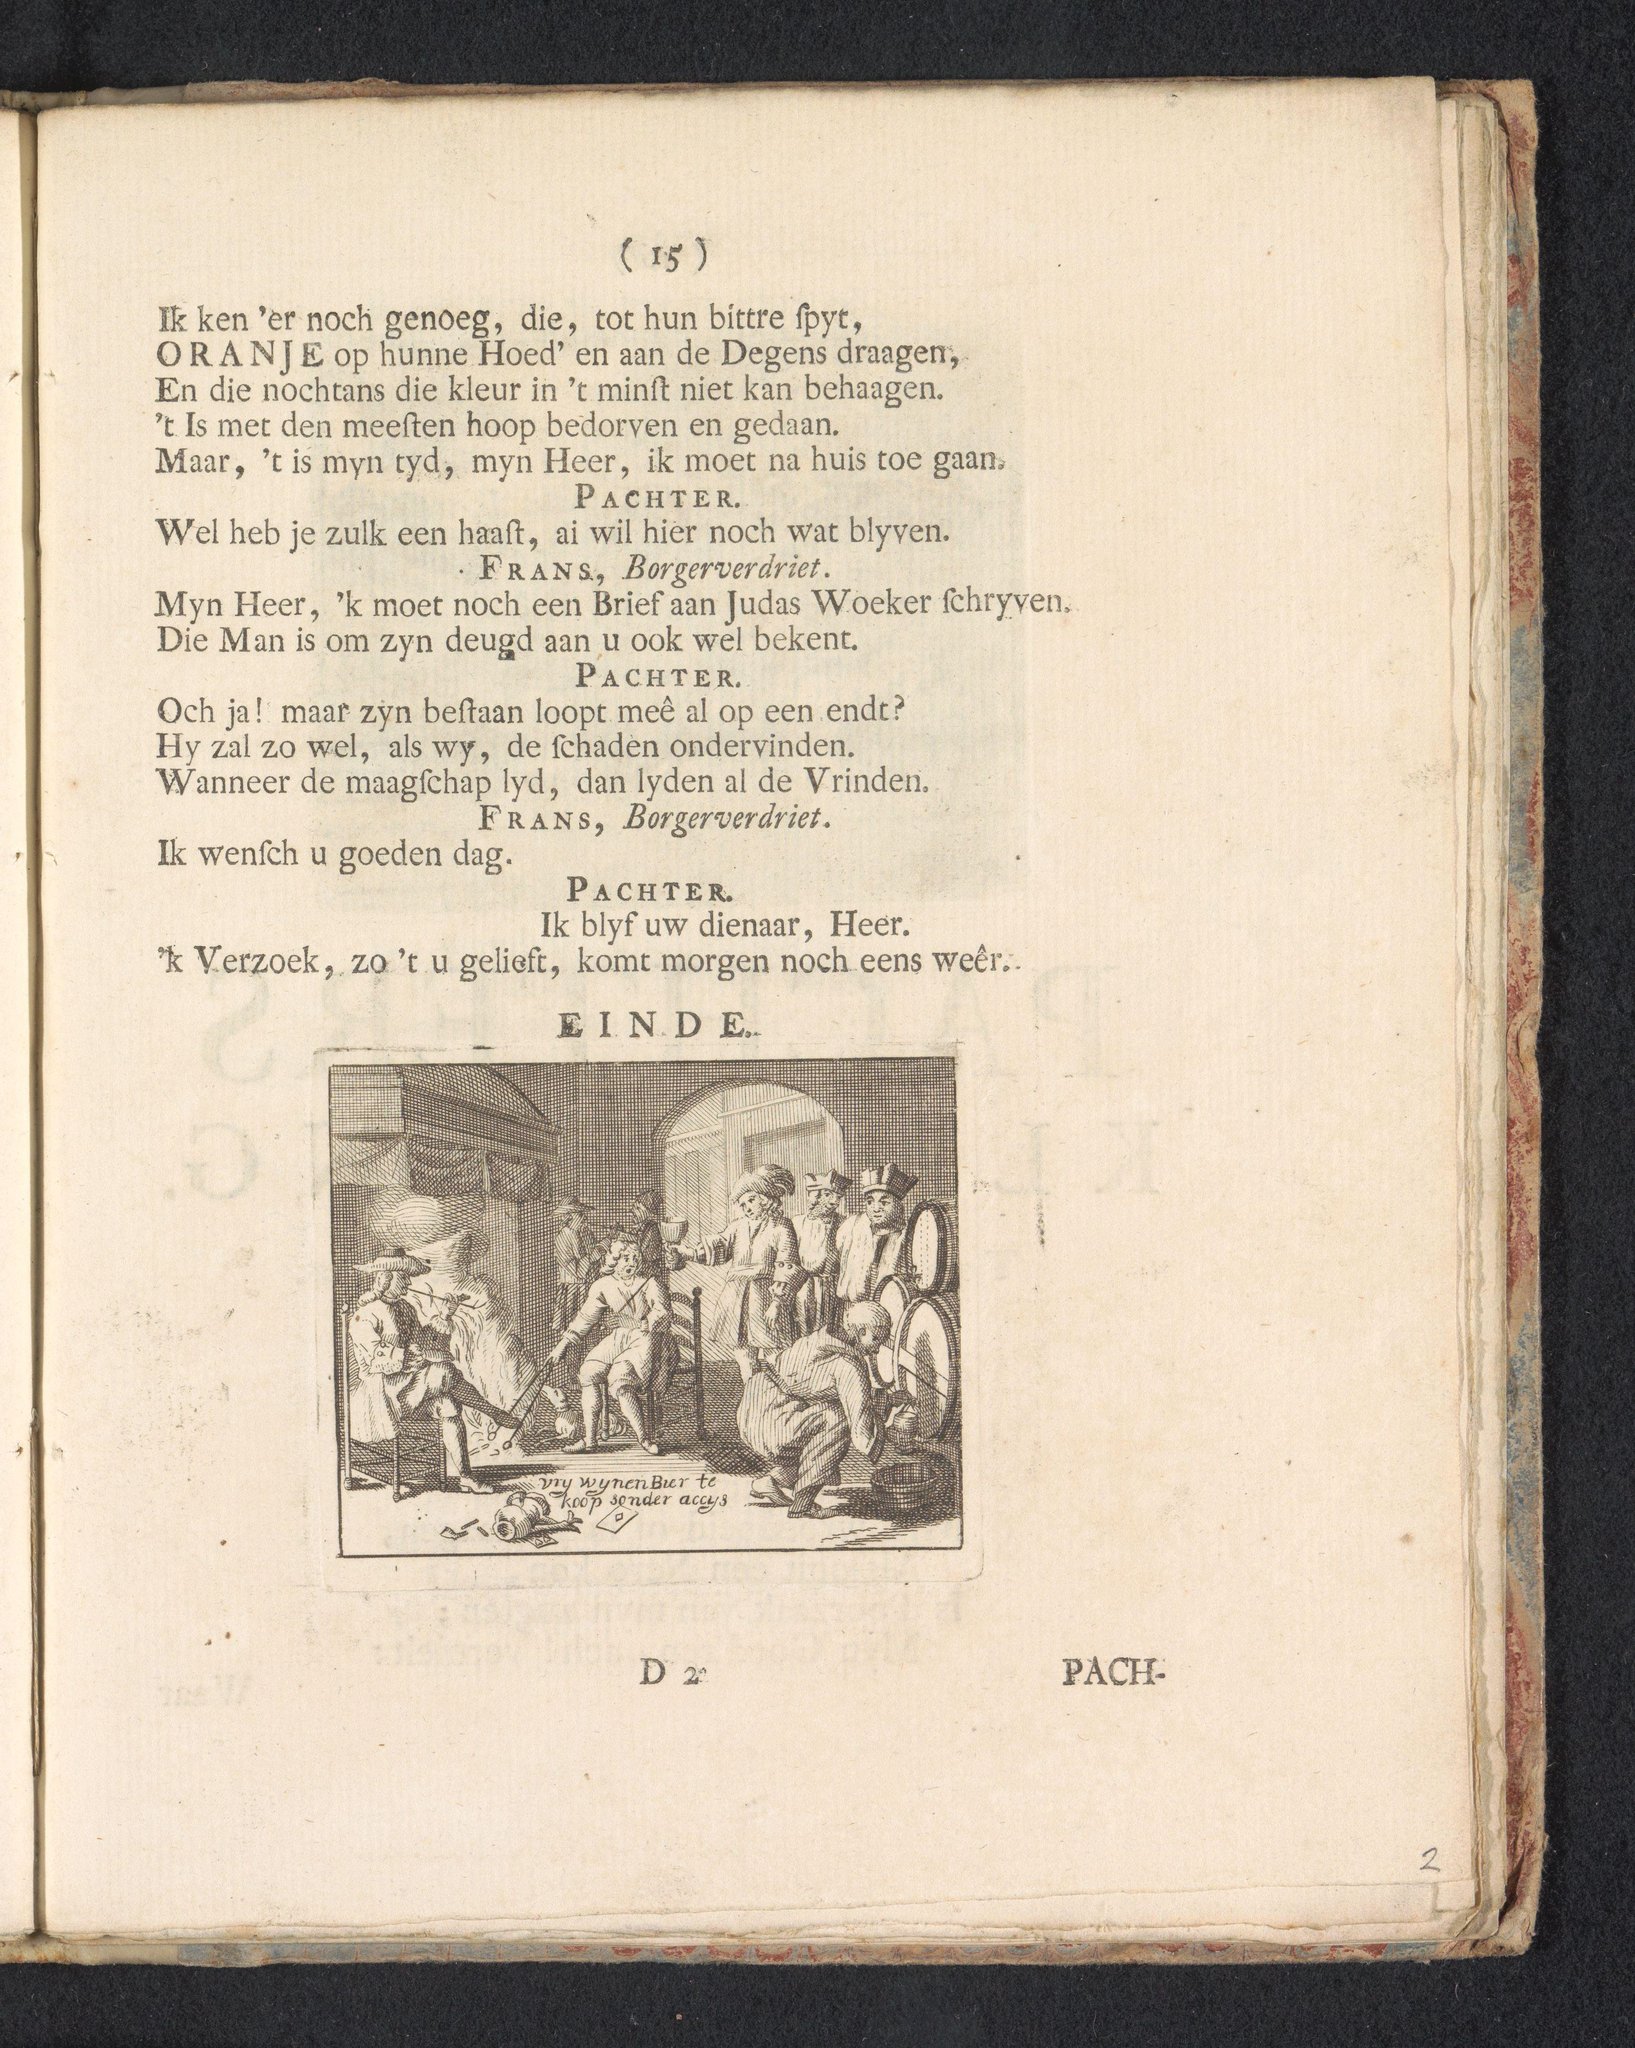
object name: print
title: Vrij wijn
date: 1748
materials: paper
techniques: engraving, etching, letterpress printing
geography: northern netherlands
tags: alcoholic drinks, amsterdam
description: Allegorische illustratie waarin wijn en bier zonder accijns verkrijgbaar is. Een monnik tapt uit een houten vat, links zitten twee mannen bij de haardvuur. Illustratie op p. 15 in het blijspel Den Bedroefden Pachter door Jan Weetal over de Pachtersoproer in 1748.